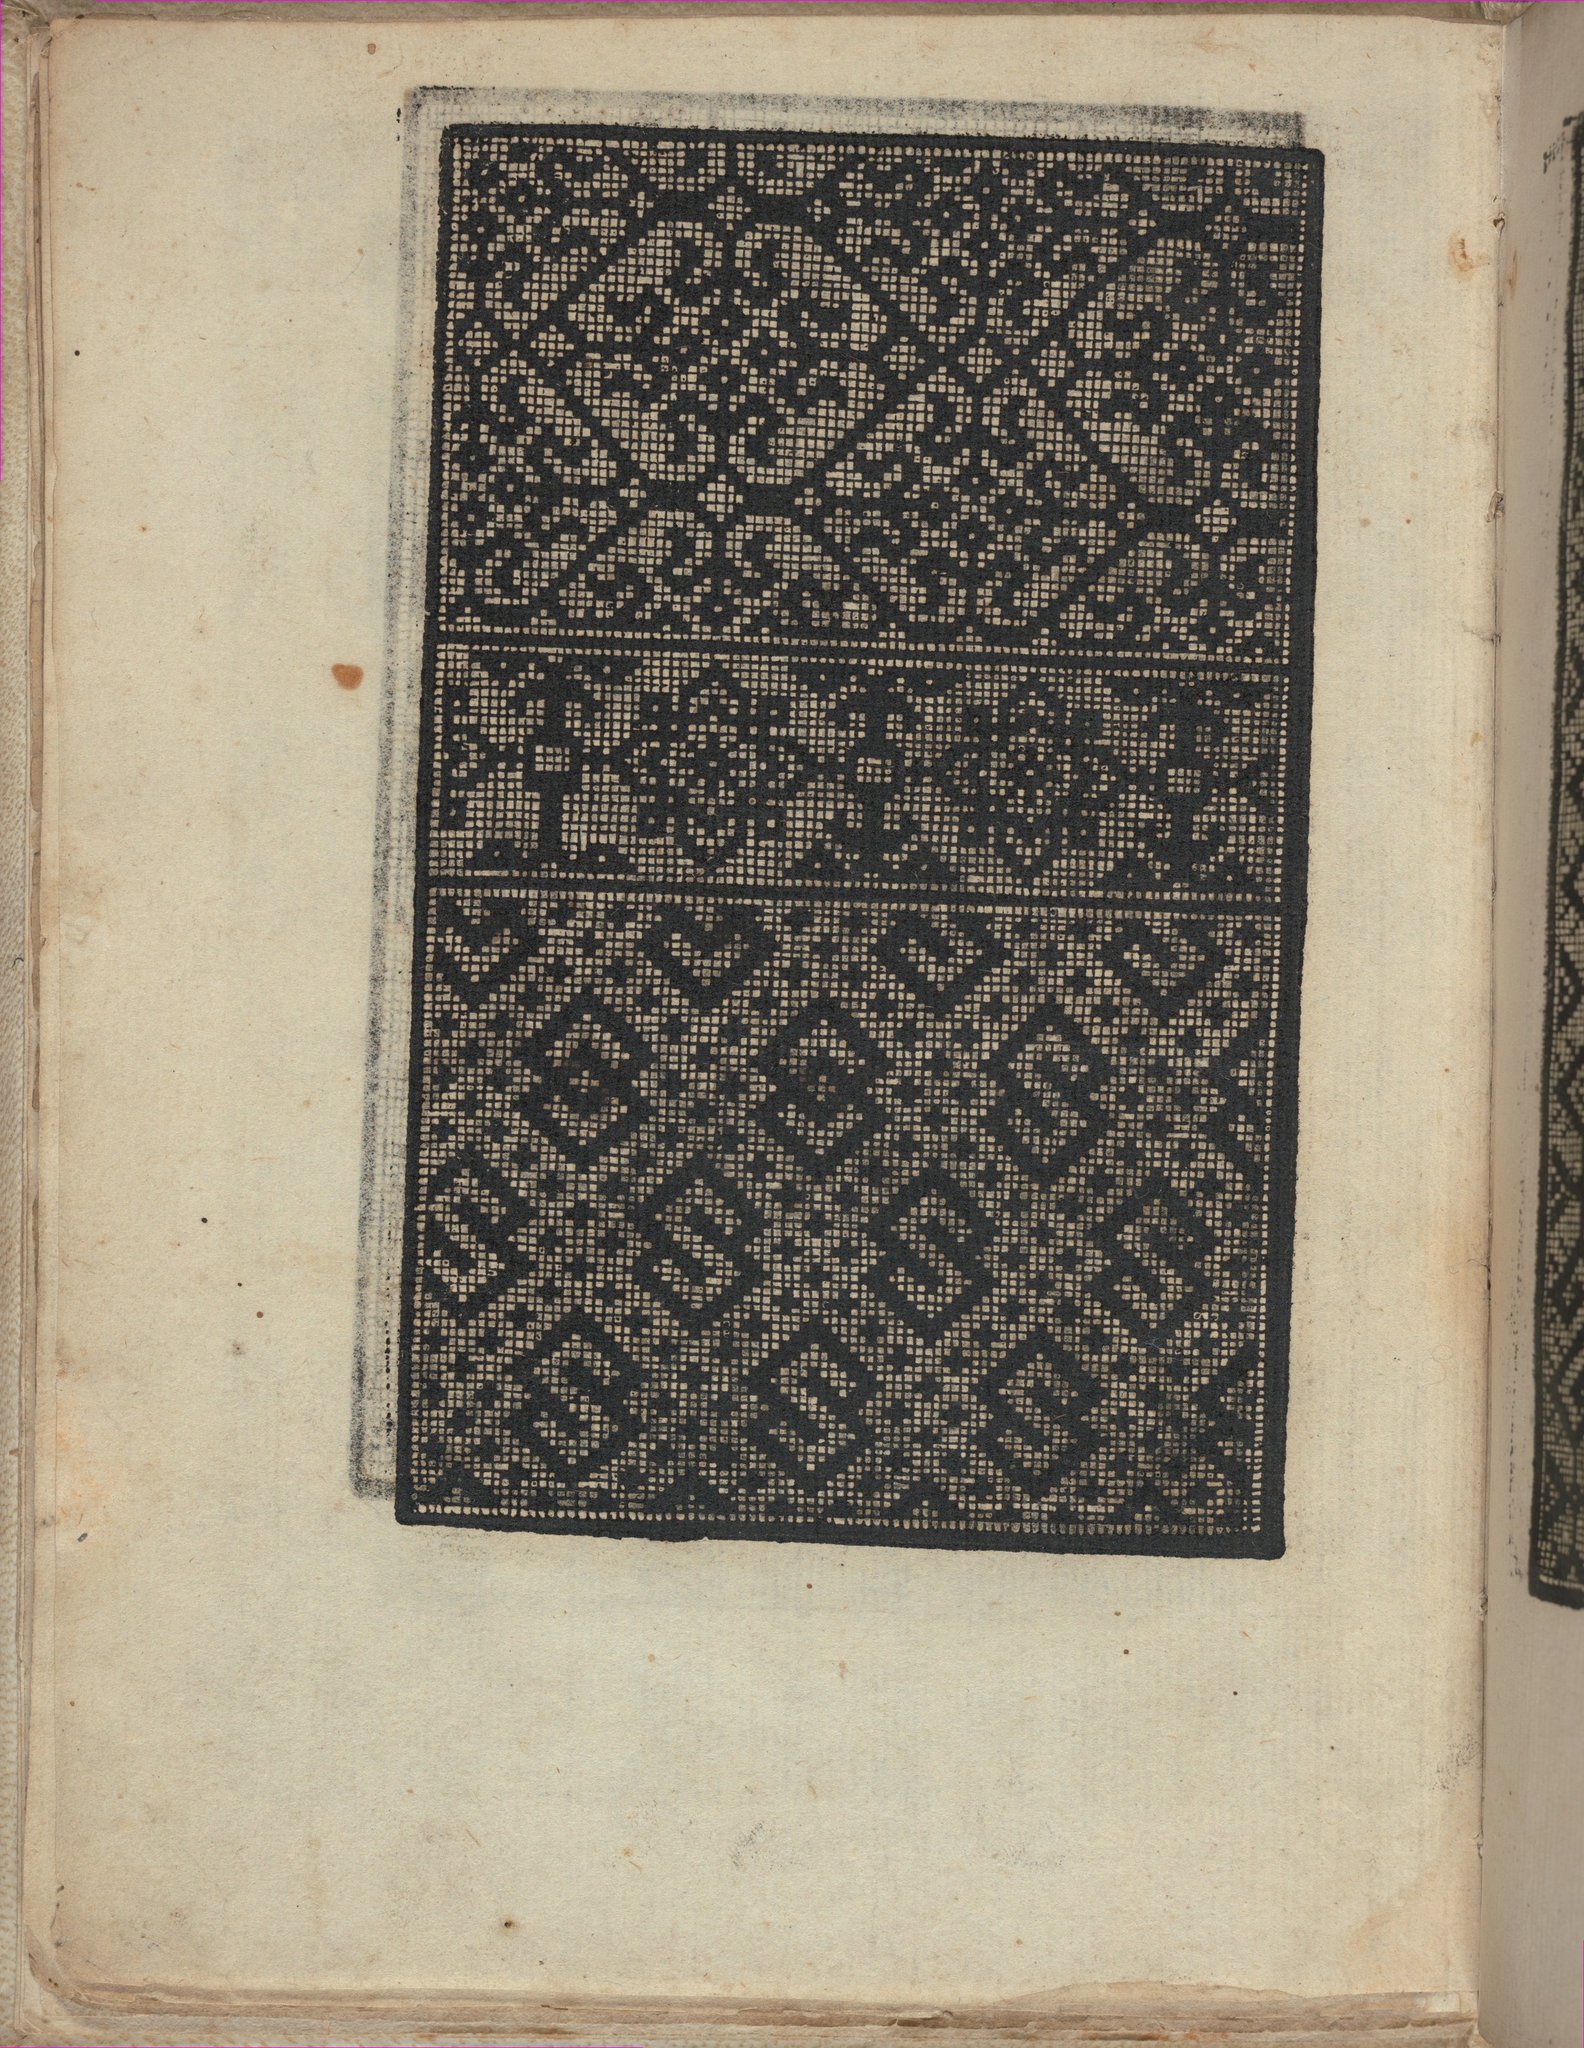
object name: book print ornament architecture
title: Esemplario di Lauori..., page 9 (recto)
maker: giovanni andrea vavassore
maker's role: publisher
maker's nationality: italian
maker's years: 1530-1573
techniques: woodcut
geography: venice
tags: ornament